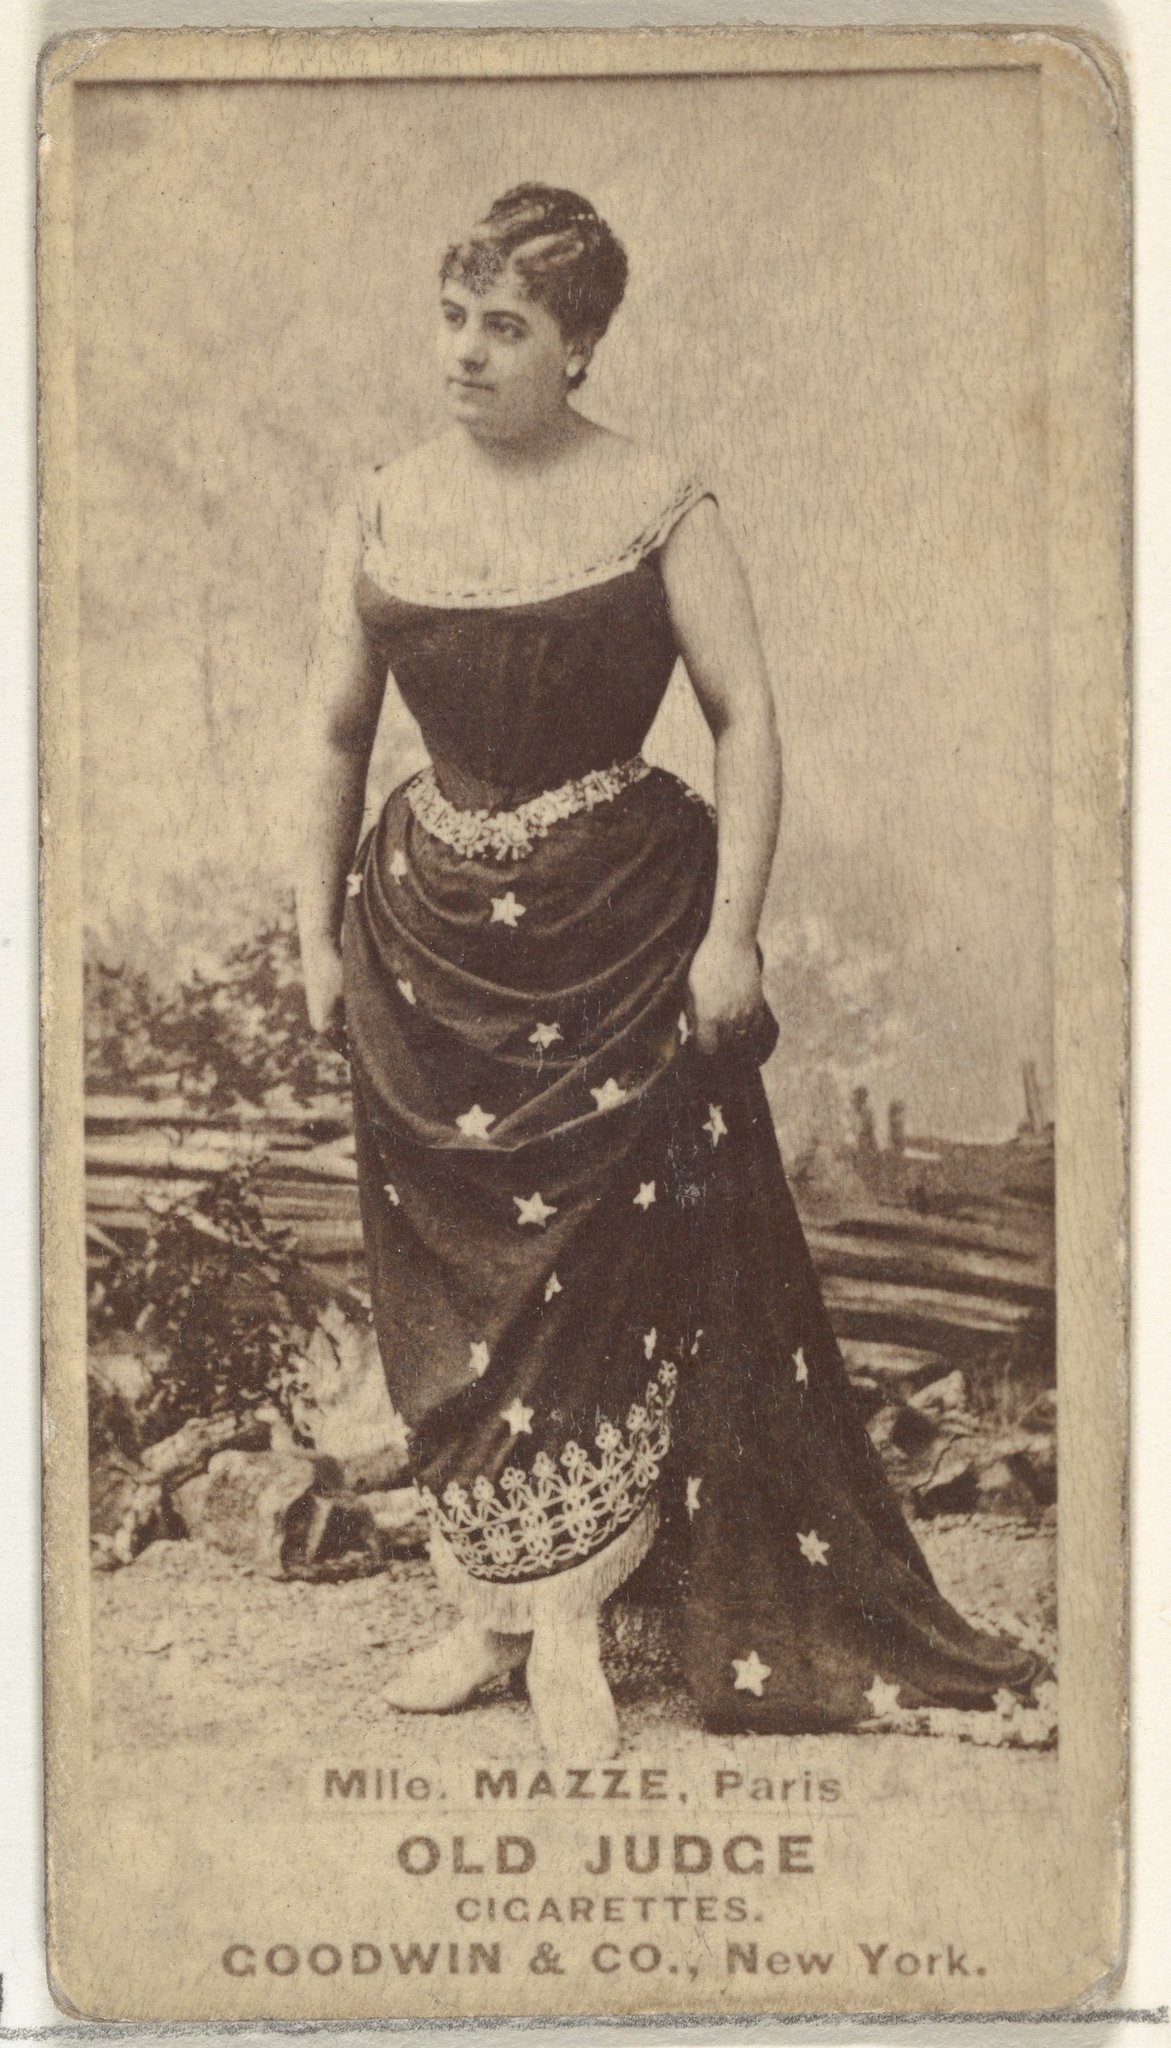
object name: photograph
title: Mlle. Mazze, Paris, from the Actors and Actresses series (N171) for Old Judge Cigarettes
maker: goodwin & company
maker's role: publisher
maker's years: 1850-1950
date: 1886-1890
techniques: albumen silver print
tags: portraits,women,actresses